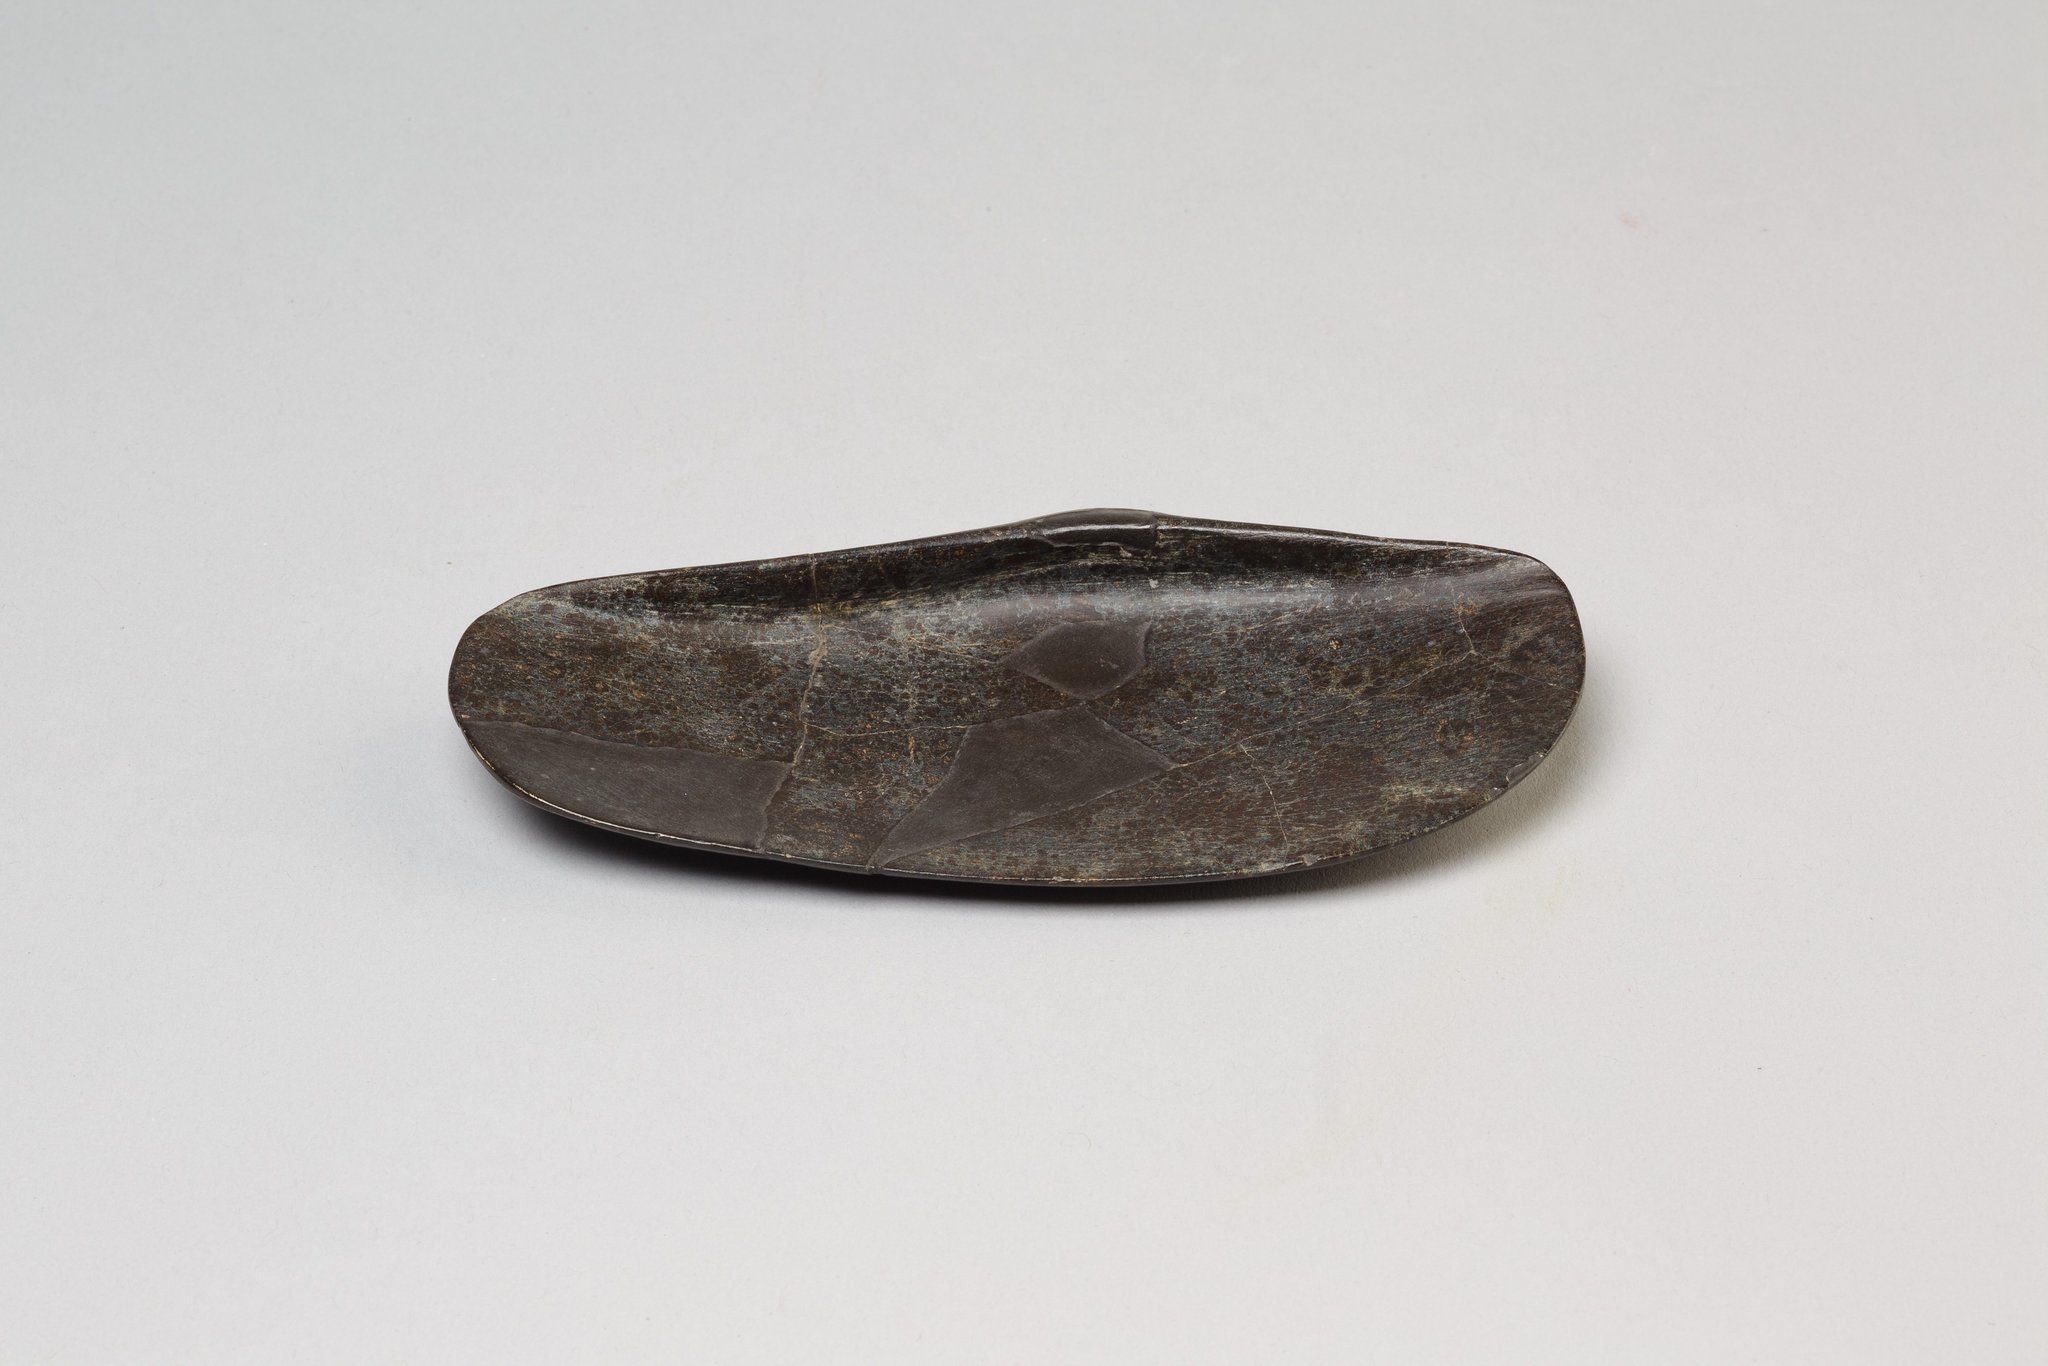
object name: ink saucer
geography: egypt